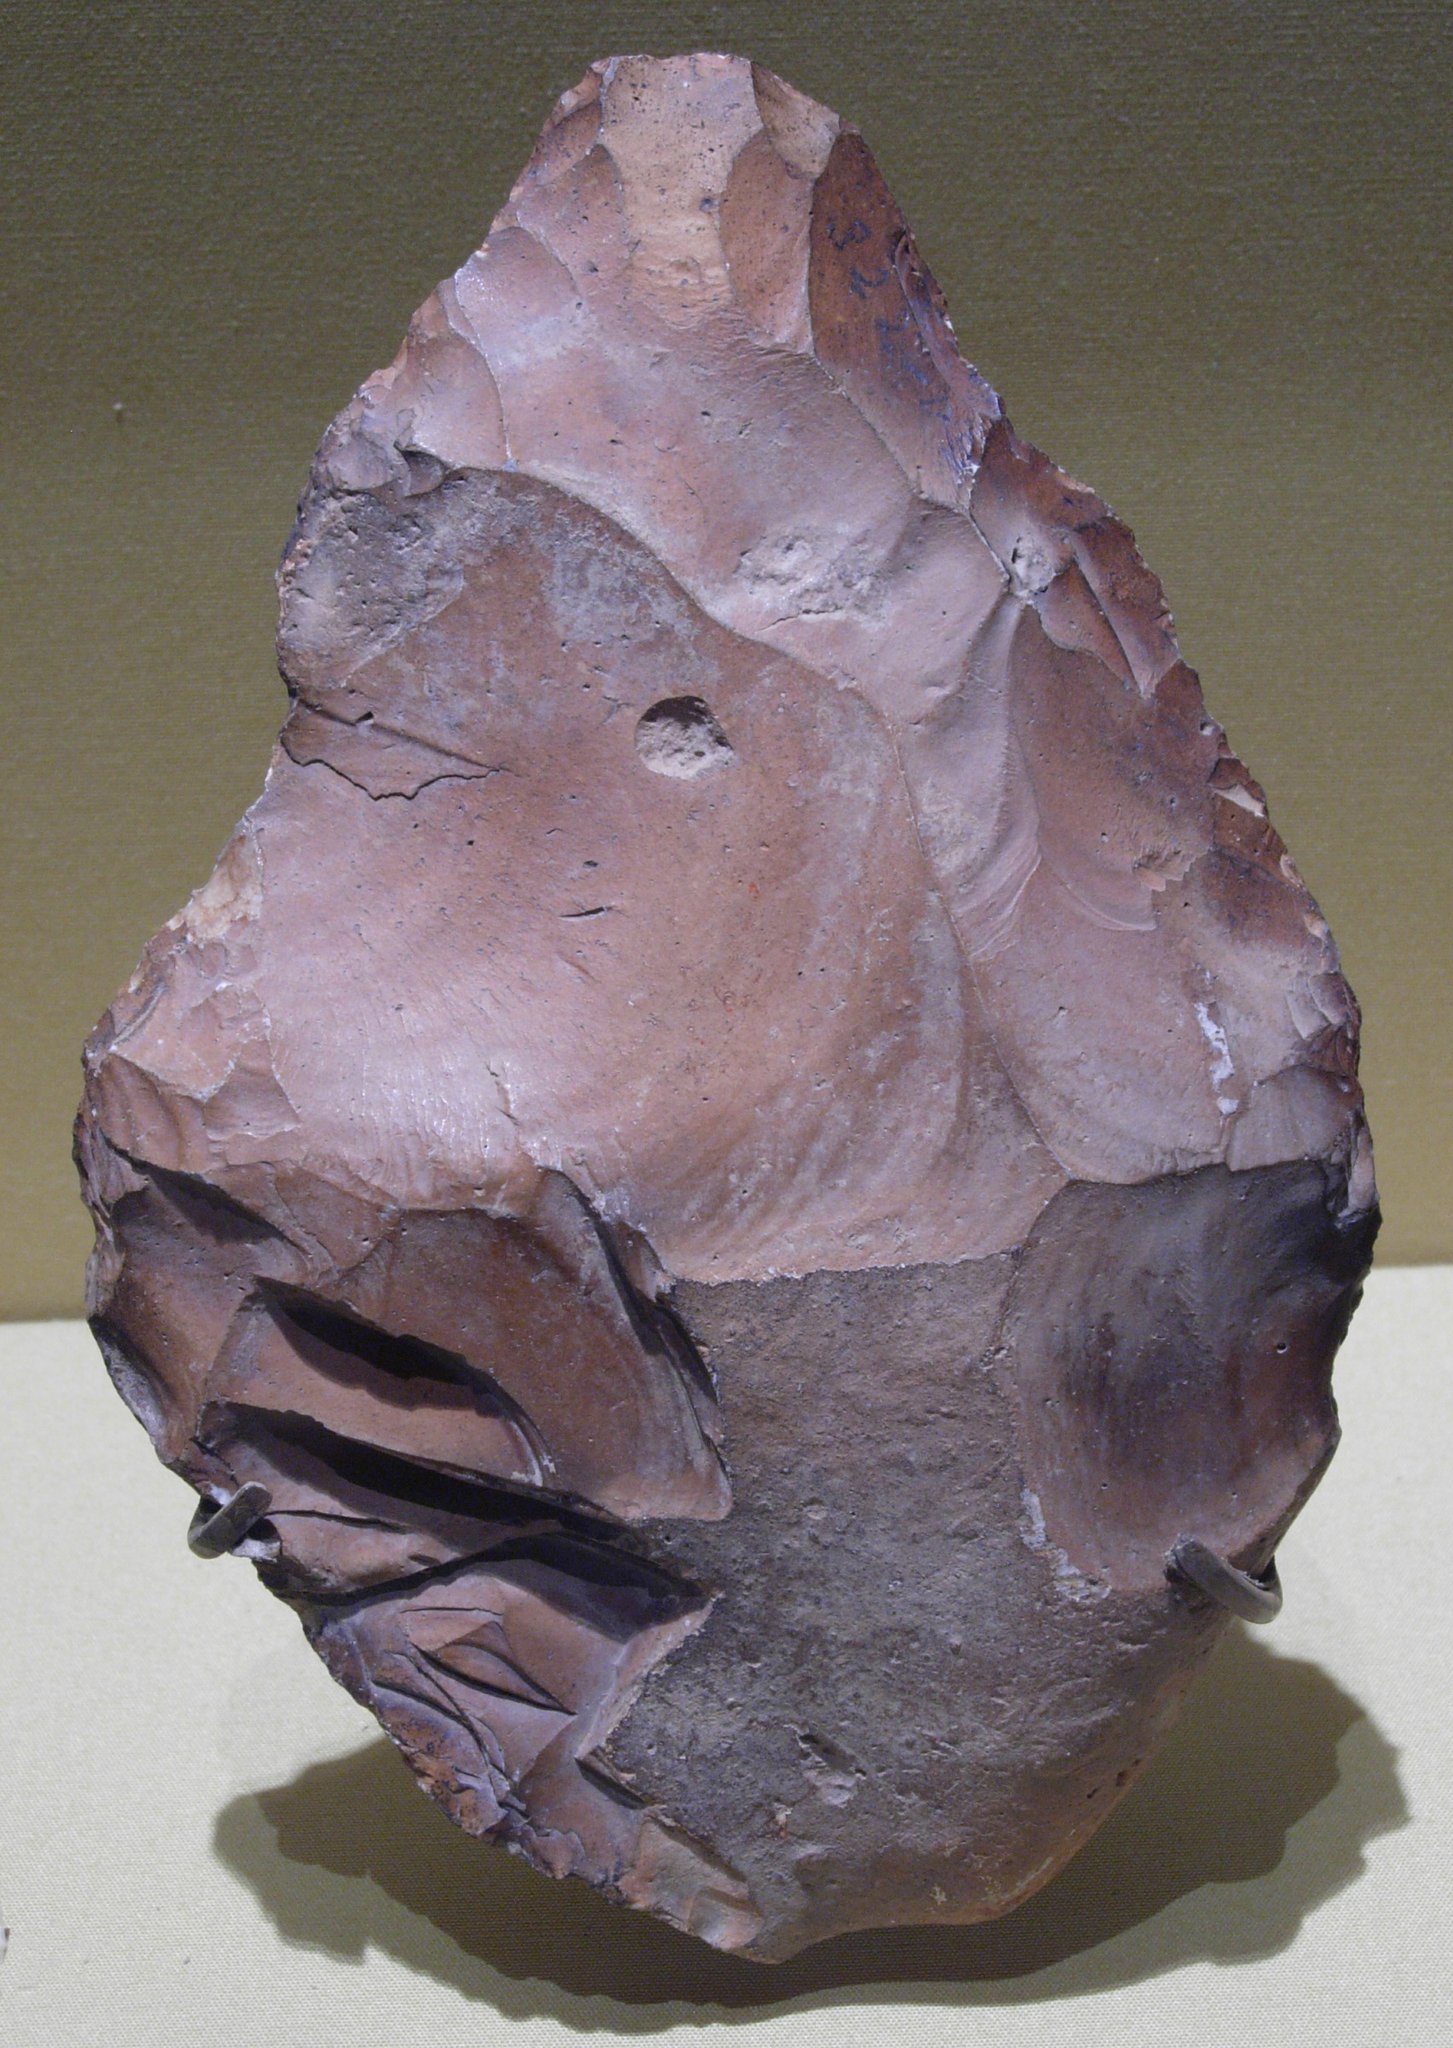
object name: tool, biface, hand ax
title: Biface, commonly referred to as a hand ax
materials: stone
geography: egypt